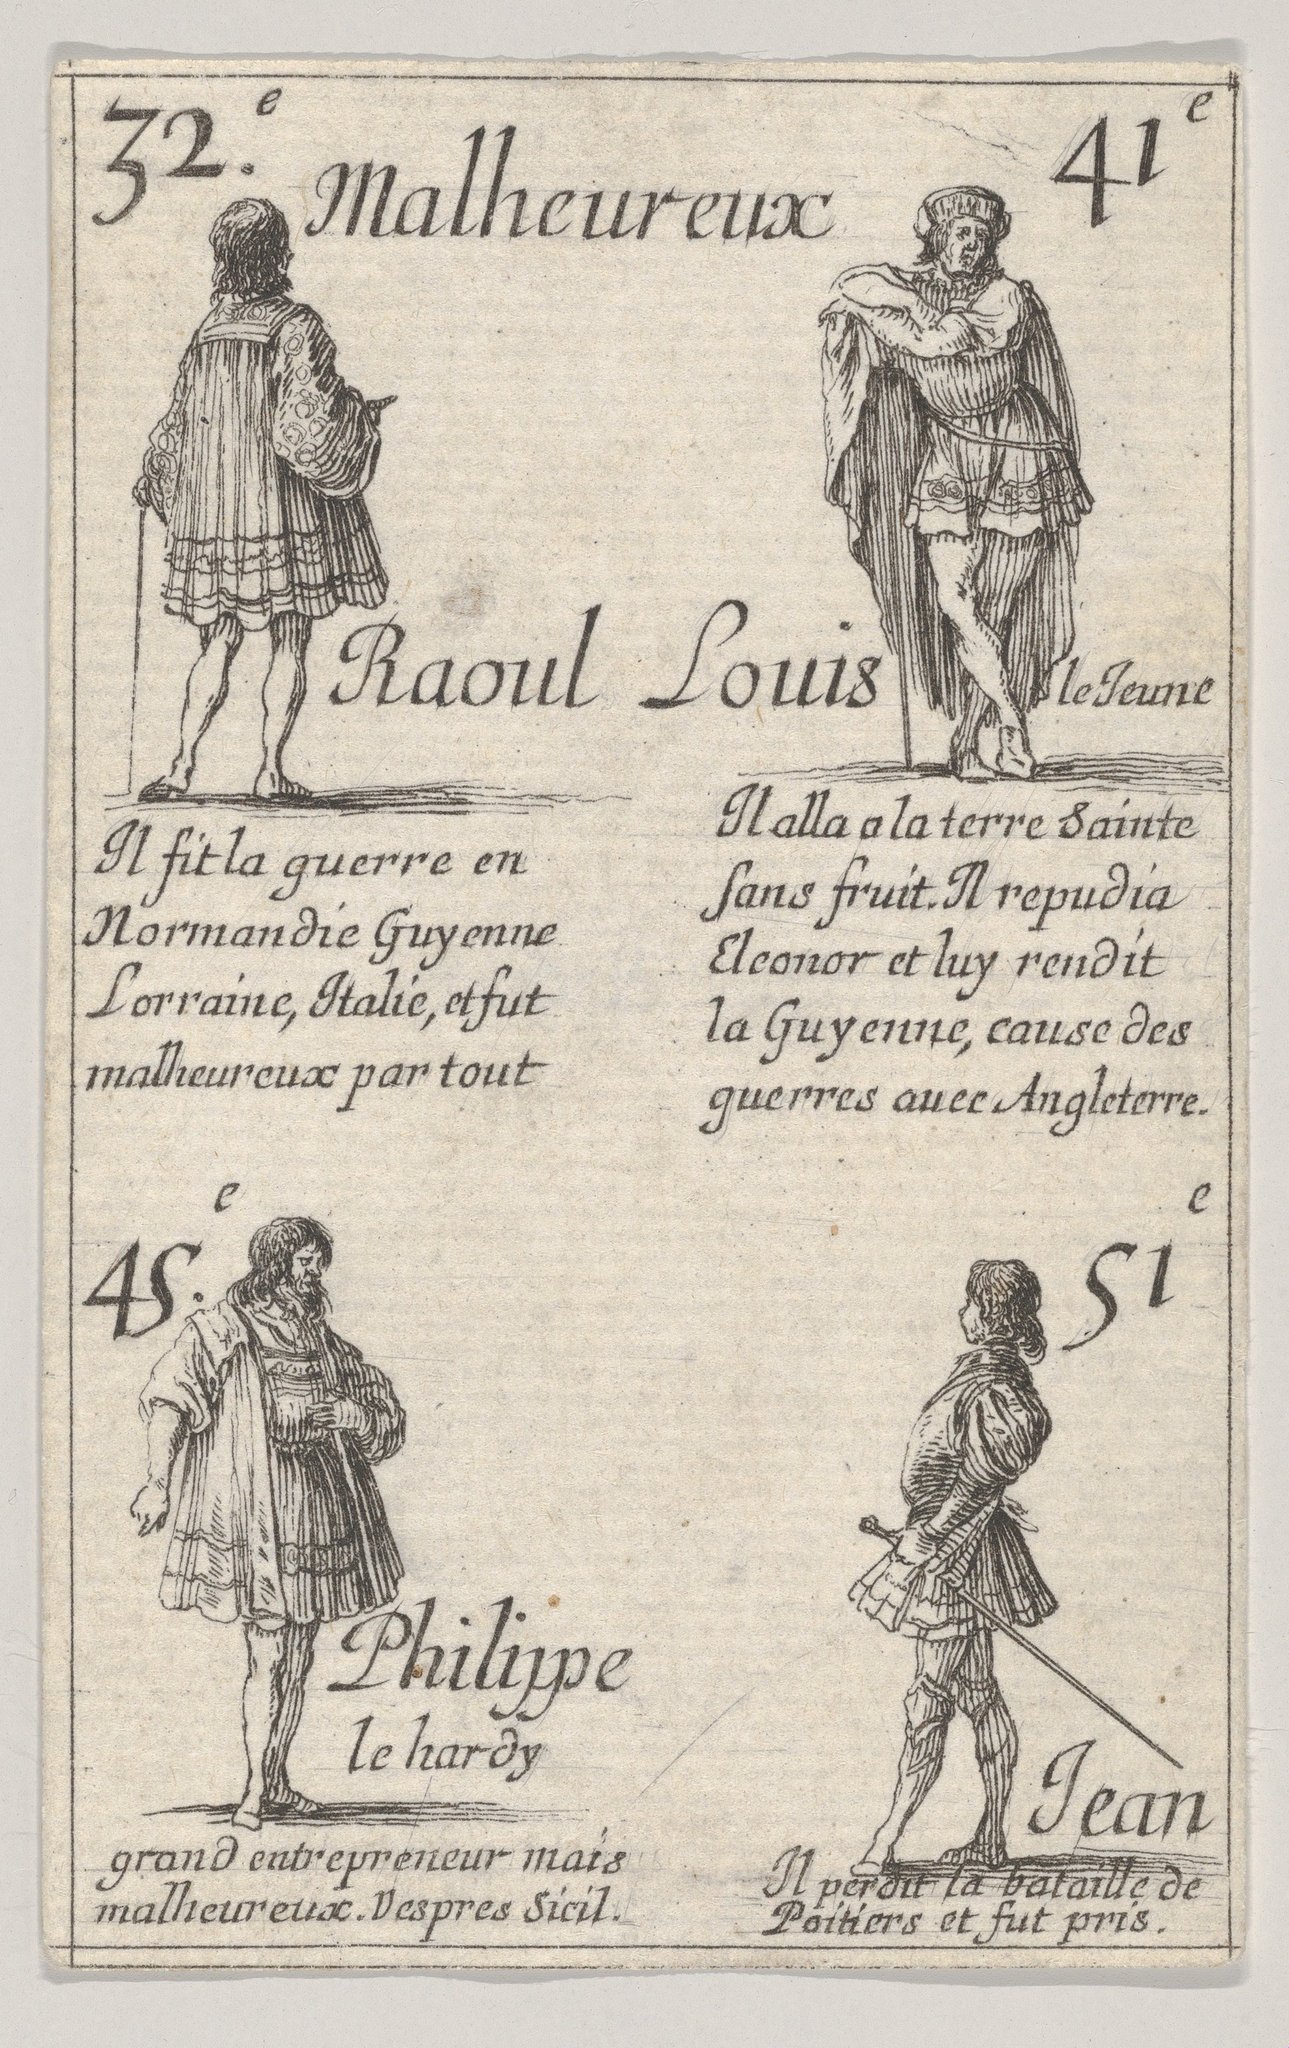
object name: print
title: Raoul ... / Louis le Jeune..., from "Game of the Kings of France" (Jeu des Rois de France)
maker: stefano della bella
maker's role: artist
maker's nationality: italian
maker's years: 1610-1664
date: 1644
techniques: etching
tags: kings